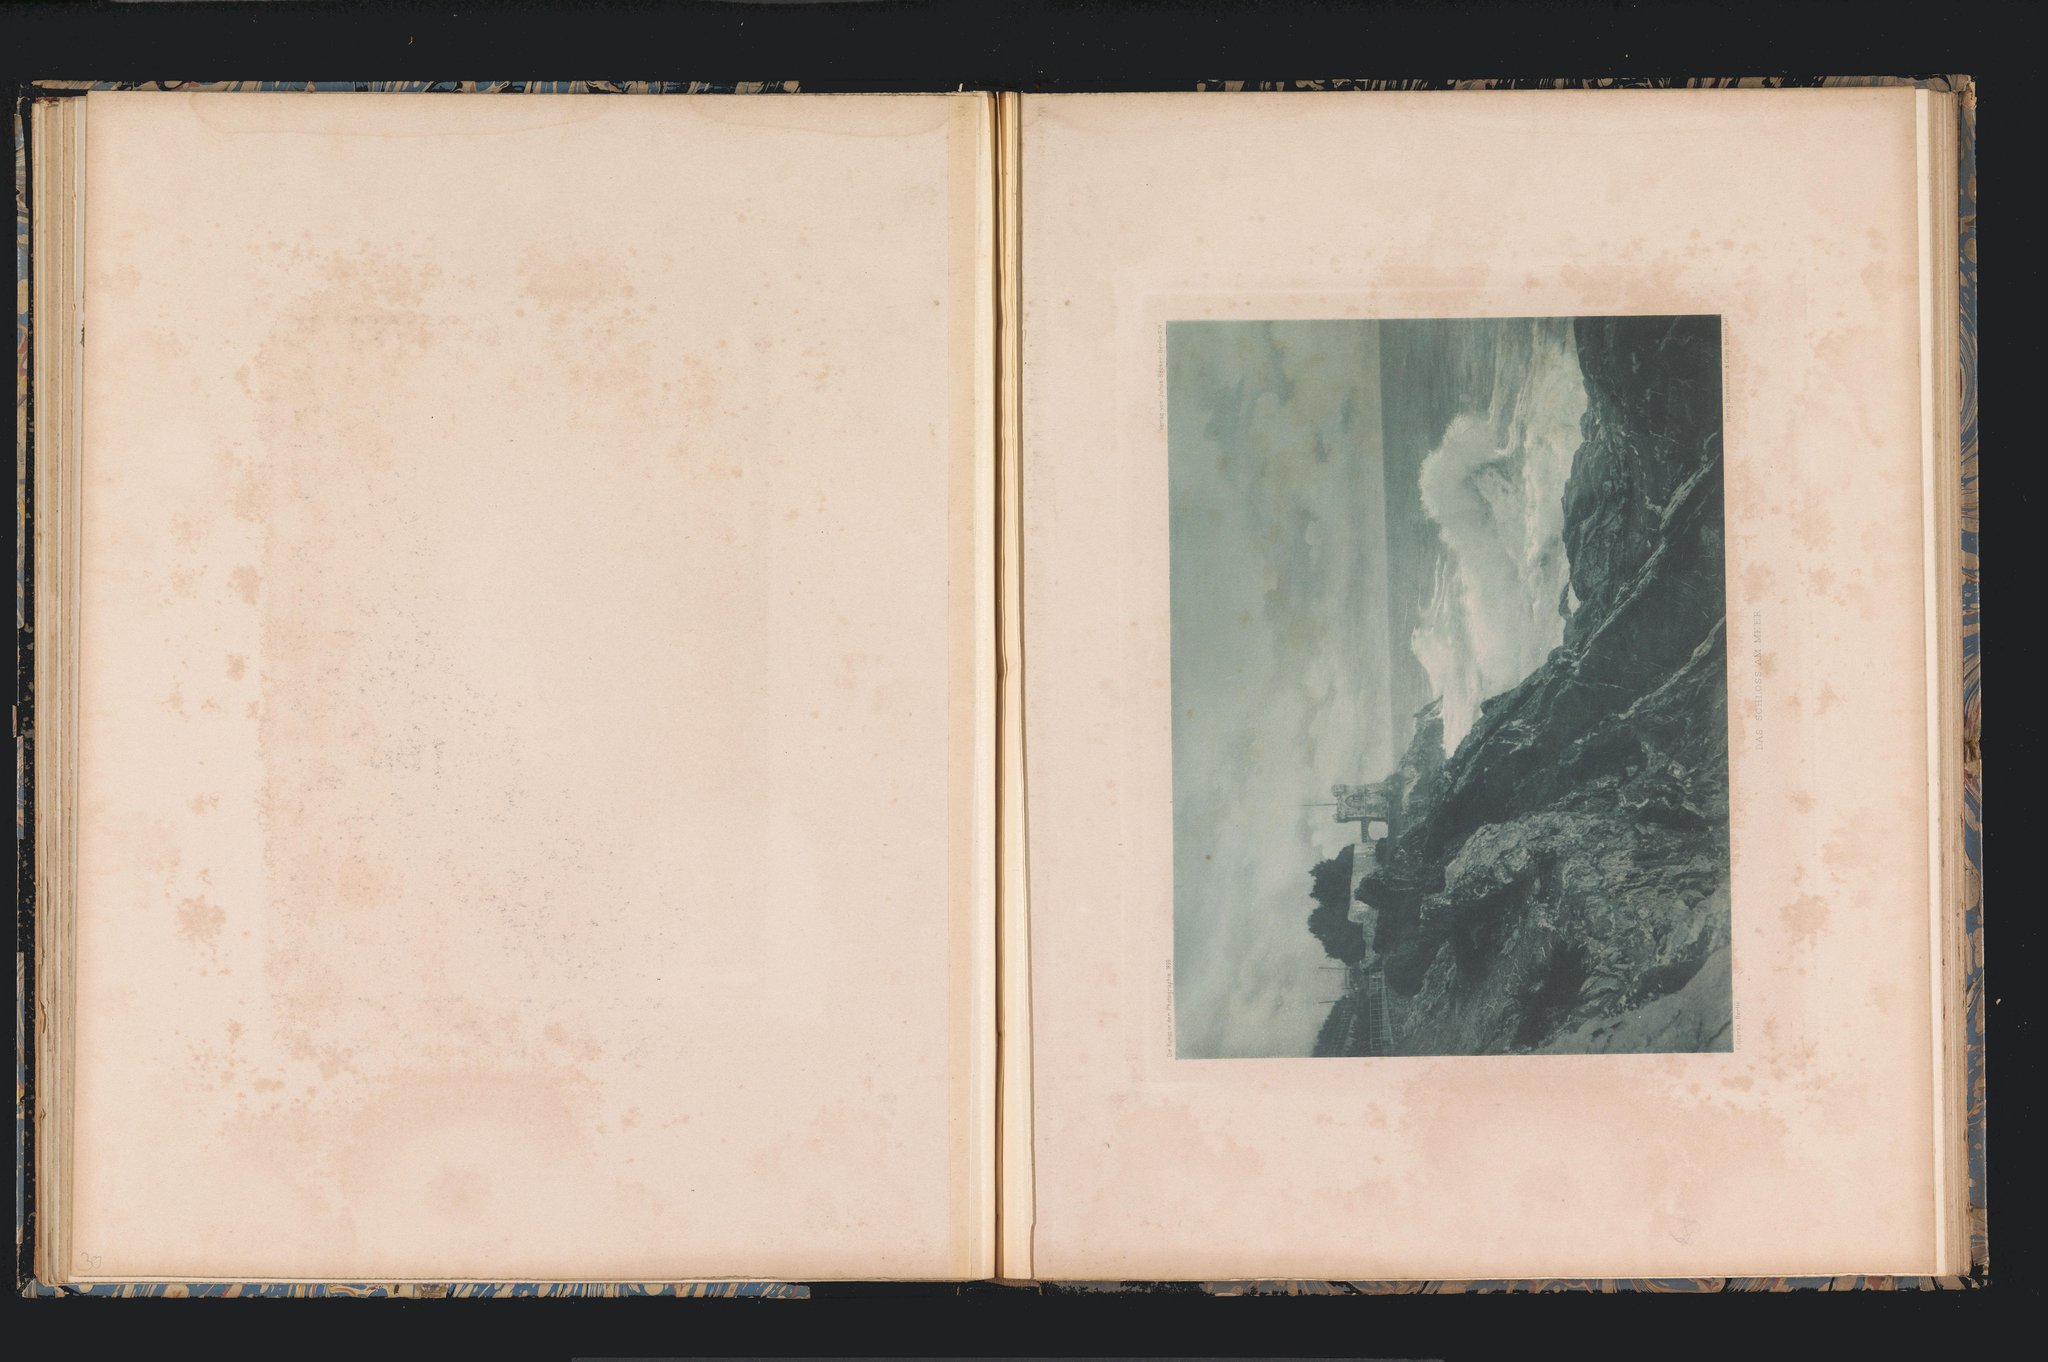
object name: page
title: Gezicht op een kasteel langs de zee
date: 1889-1899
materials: paper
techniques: photoaquatint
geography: germany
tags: castle, rocky coast